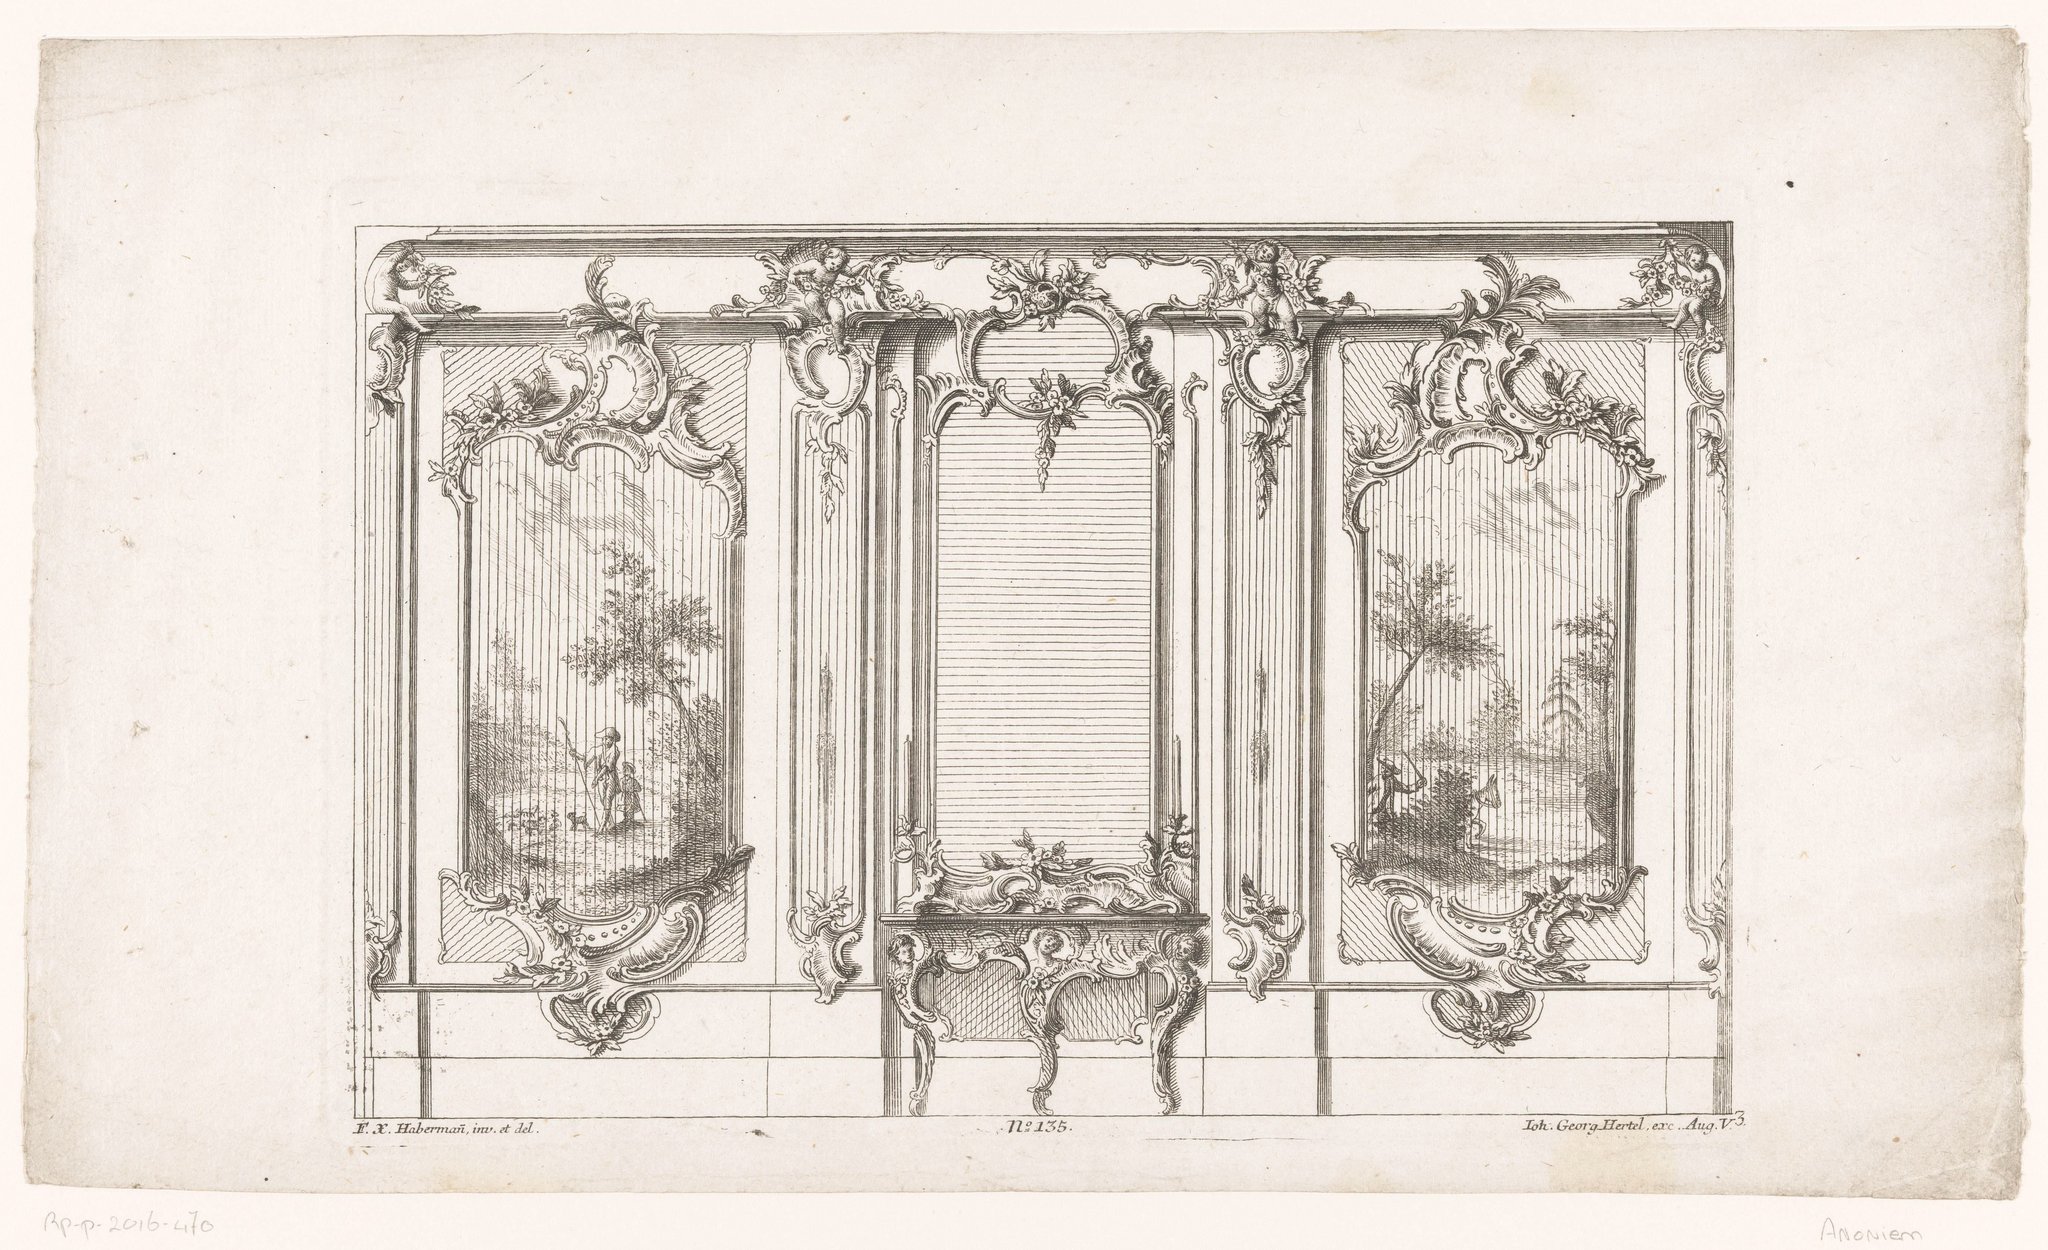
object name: ornament print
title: Wandindeling met panelen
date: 1748-1753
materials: paper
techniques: engraving, etching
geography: augsburg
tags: rocaille ornament, panelling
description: Wandindeling met twee panelen met pastorale scènes, met rocaille omlijsting. Op de voorgrond een met rocailles versierde tafel. Uitgeversnummer 135.